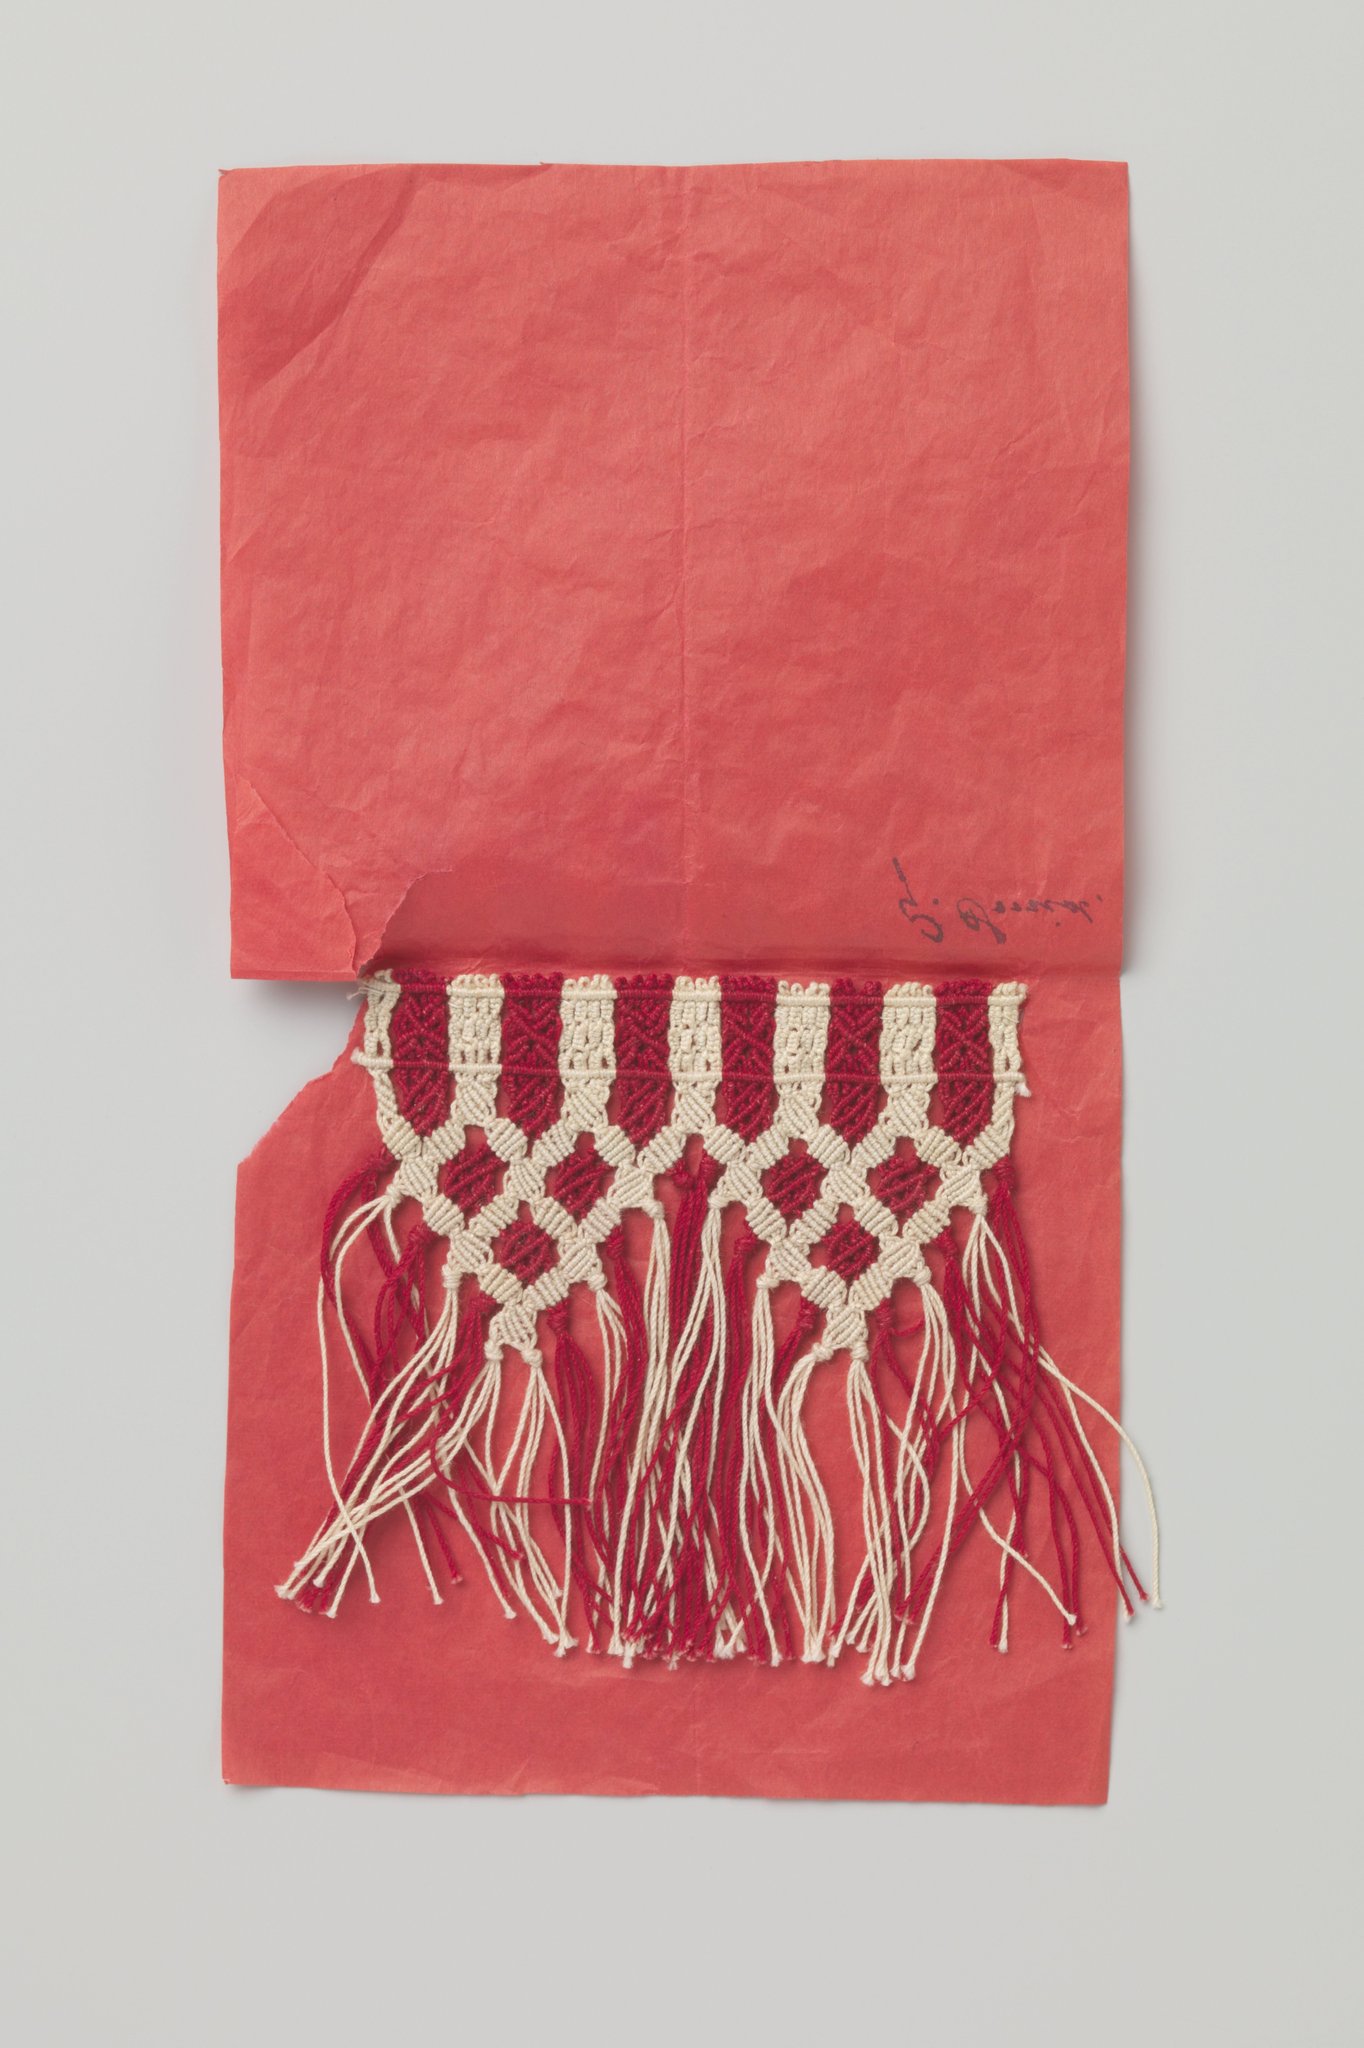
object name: werkstuk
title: Werkstuk voor Diploma fraaie handwerken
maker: geesje smid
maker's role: artisan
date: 1890-1900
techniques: macrame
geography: netherlands